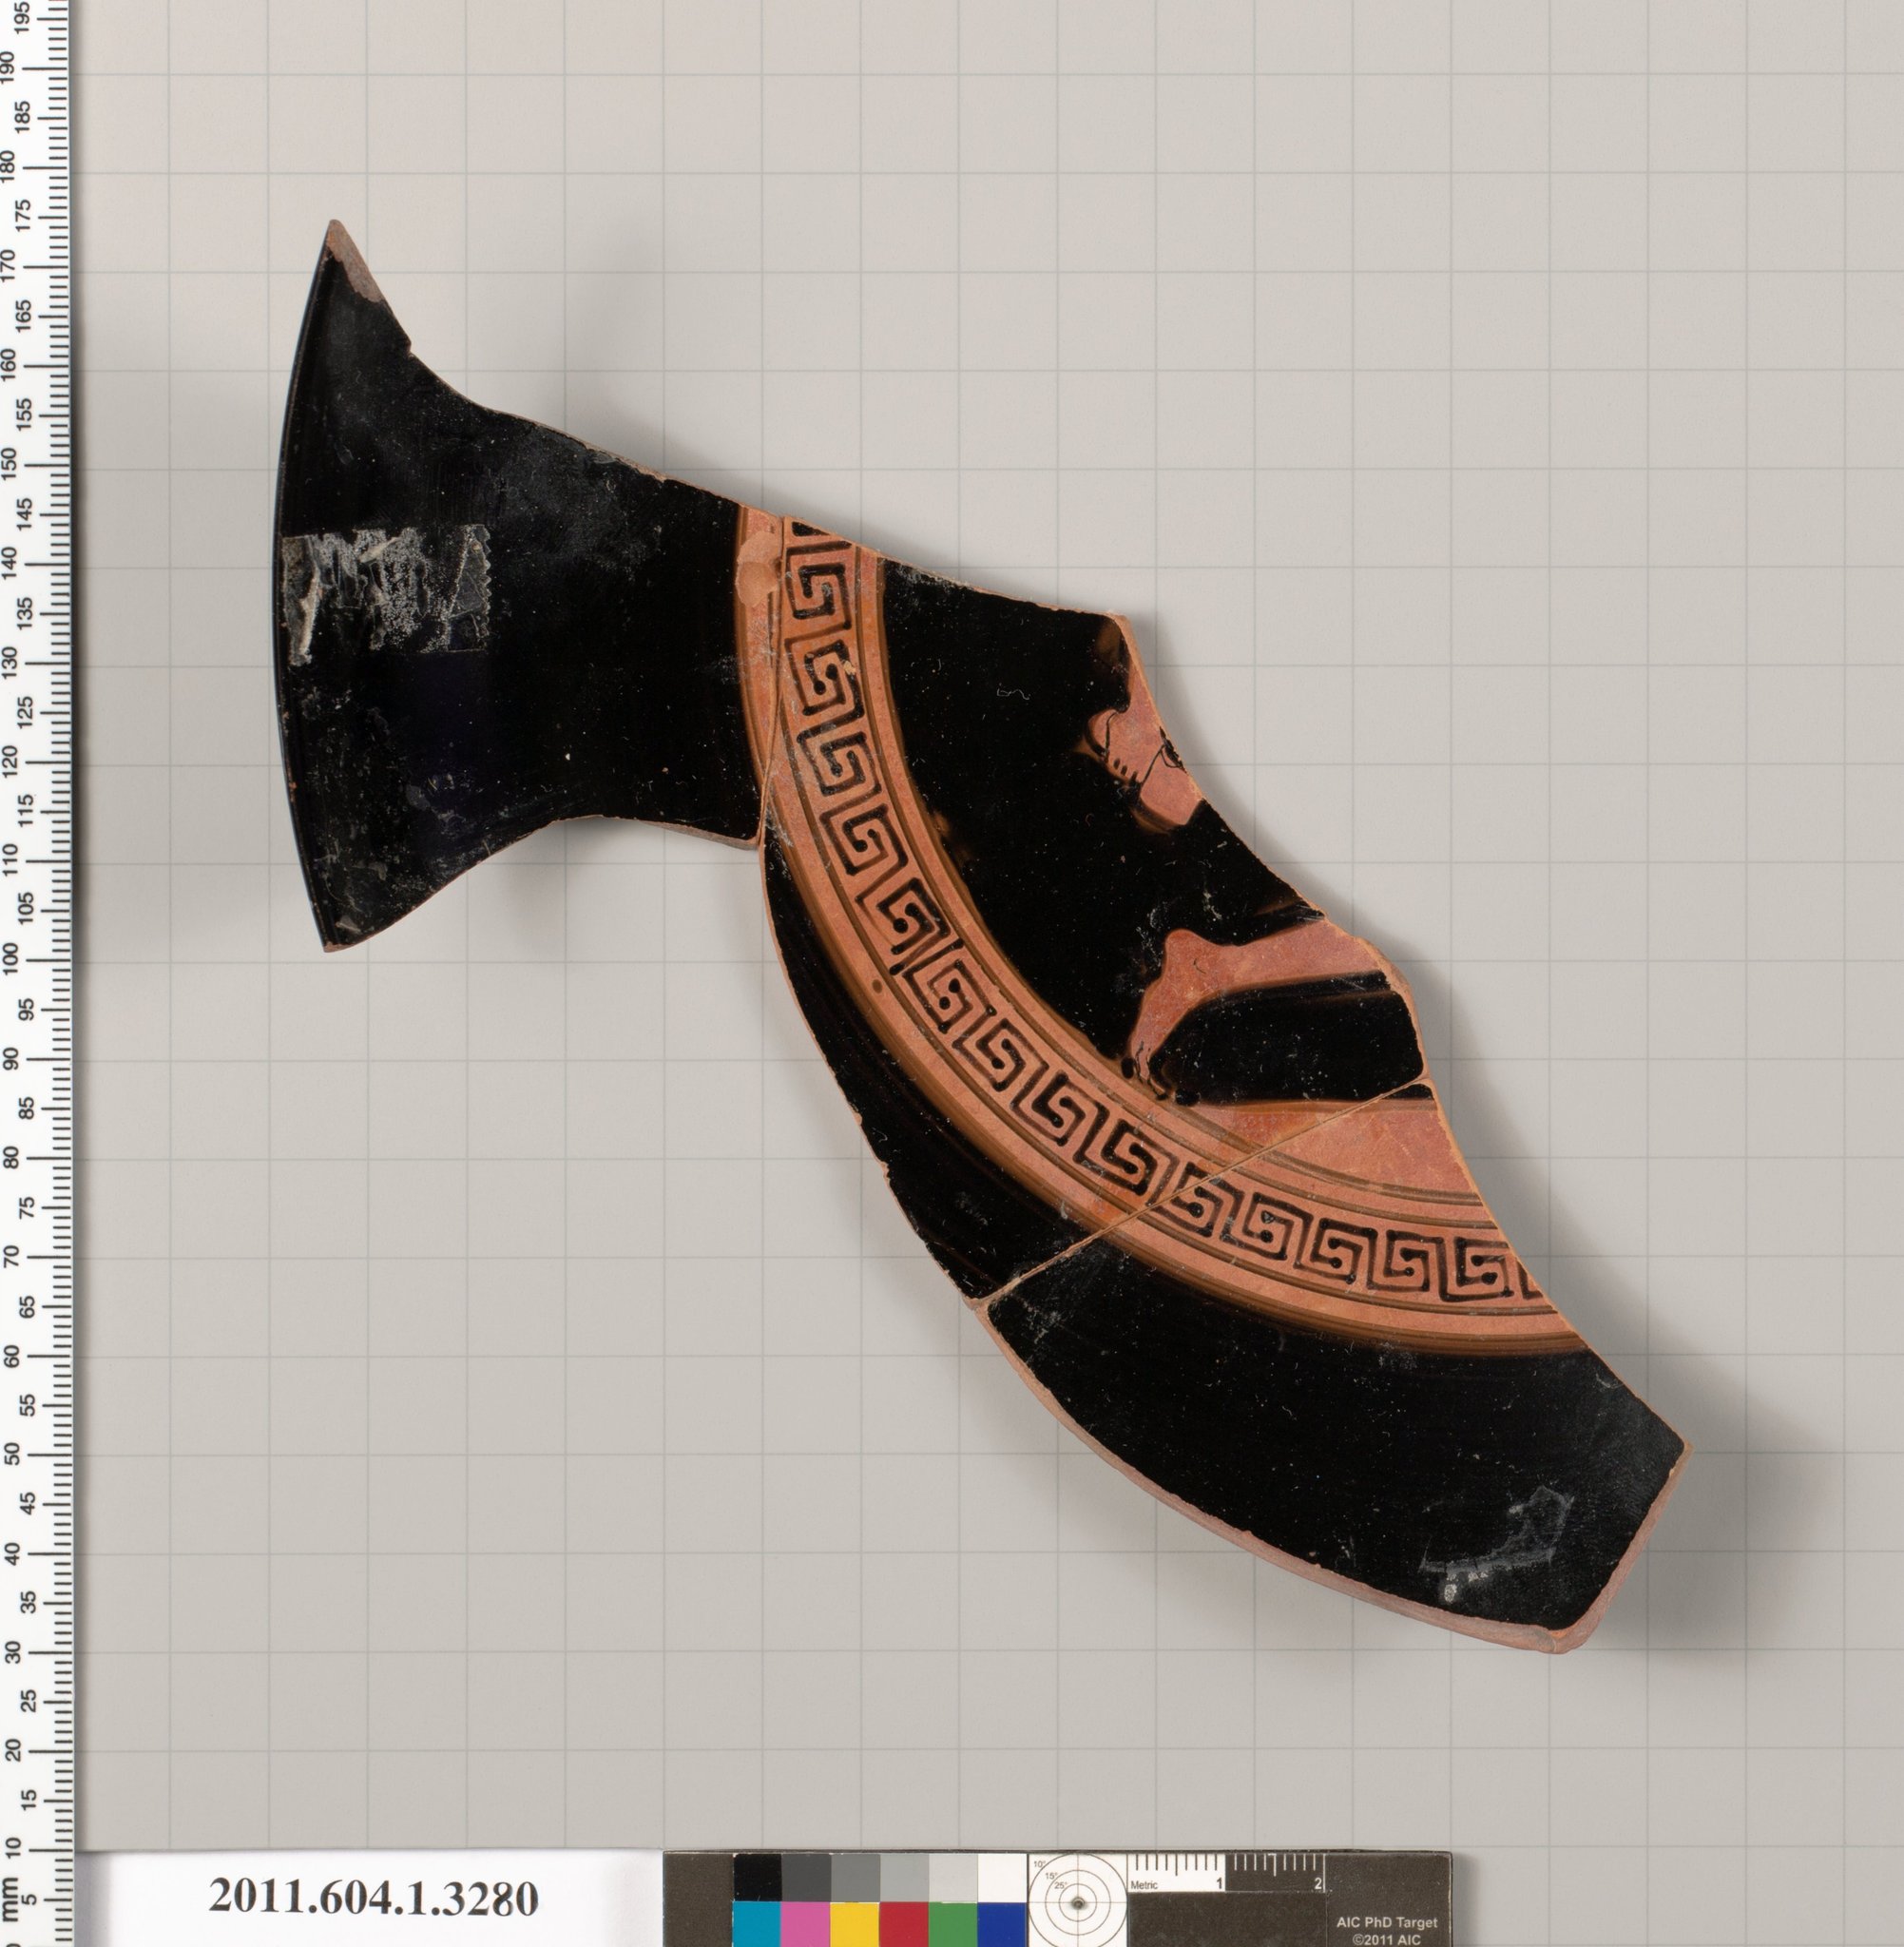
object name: kylix fragment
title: Terracotta fragment of a kylix (drinking cup)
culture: greek, attic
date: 475-451 BCE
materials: terracotta